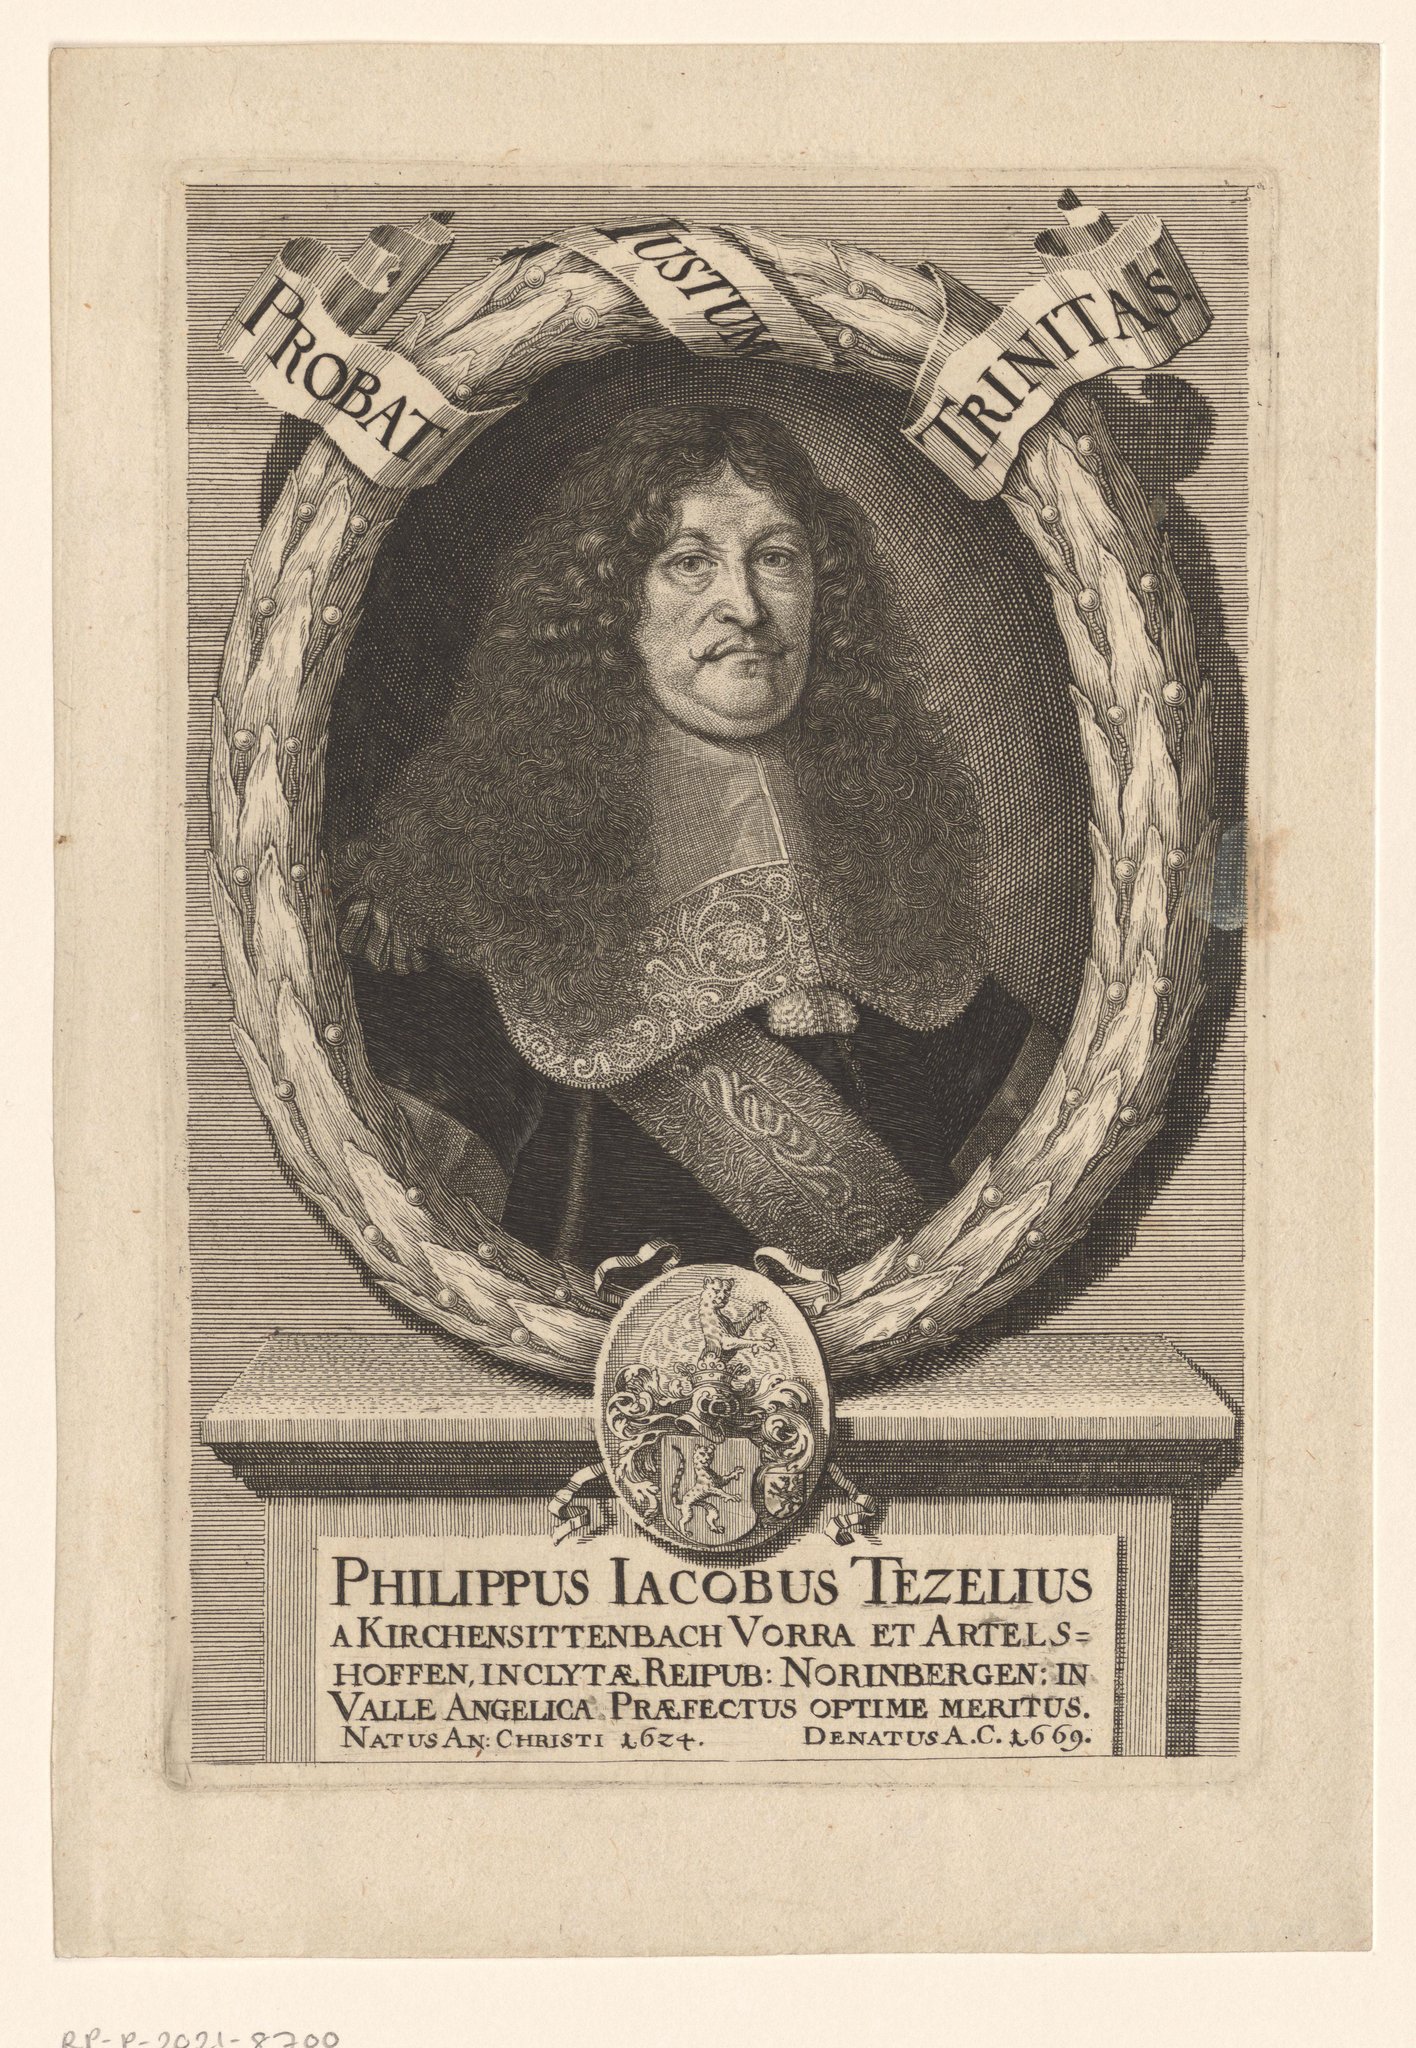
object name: print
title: Portret van Philipp Jacob Tetzel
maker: jakob von sandrart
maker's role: print maker, publisher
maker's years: 1630-1708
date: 1669-1700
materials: paper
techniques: engraving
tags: historical persons, armorial bearing, heraldry